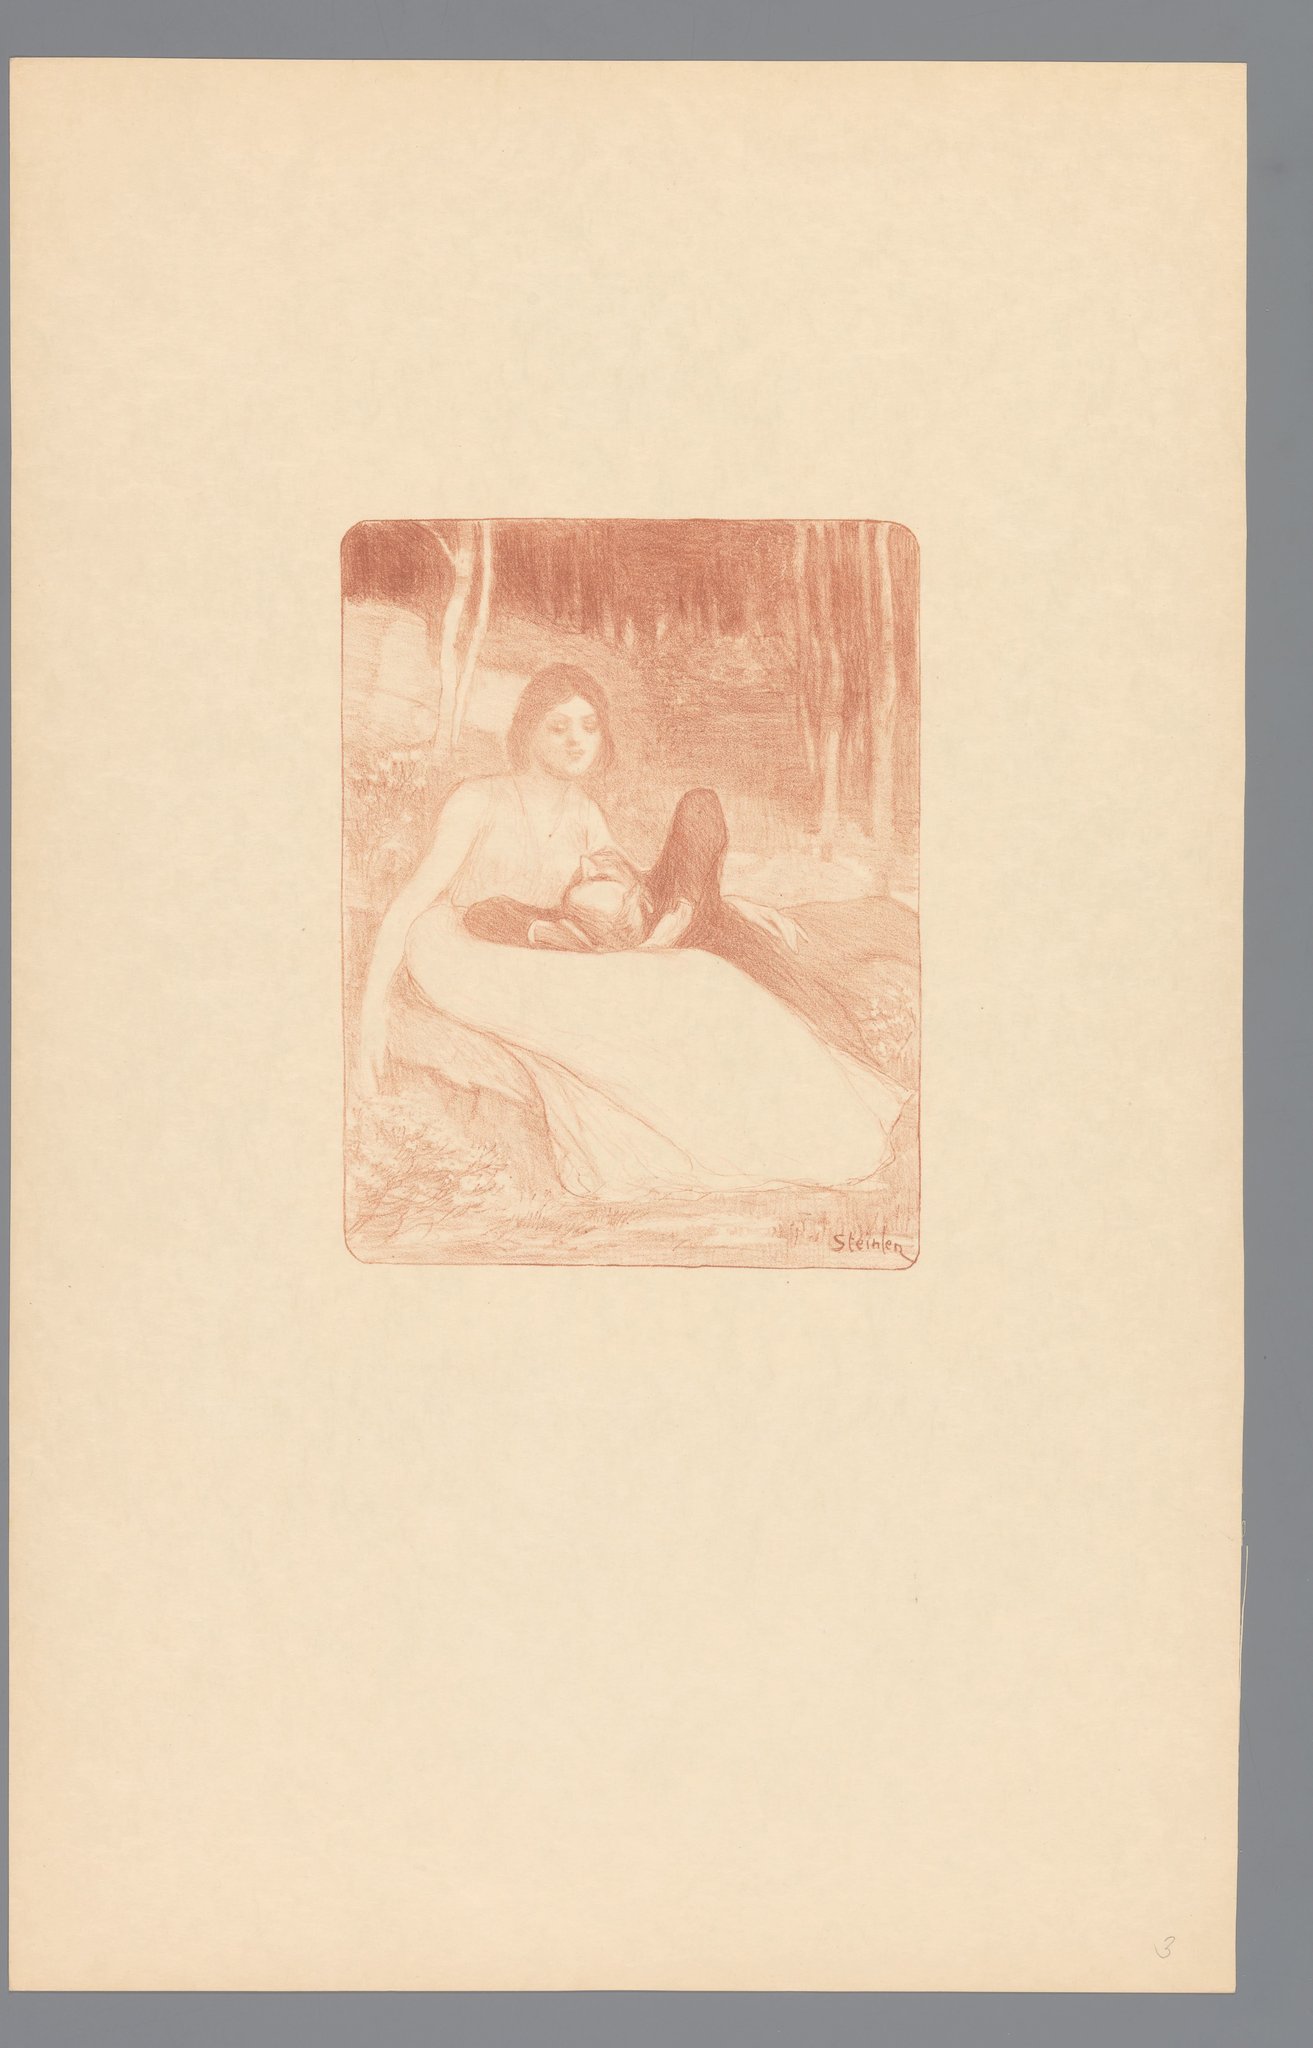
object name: print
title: Chansons de femmes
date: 1897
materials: paper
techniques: lithograph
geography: paris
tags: park, lovers' meeting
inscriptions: collector's mark: Lugt 2760, collector's mark: Lugt 2228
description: Een vrouw in een witte japon zit, bij avond, op een talud in een park. Een man in een donker pak ligt met zijn hoofd in haar schoot te slapen. Rechtsonder gesigneerd 'Steinlen'. No.10 uit een serie van 15 litho's voor de map 'Chansons de Femmes' van Paul Delmet.